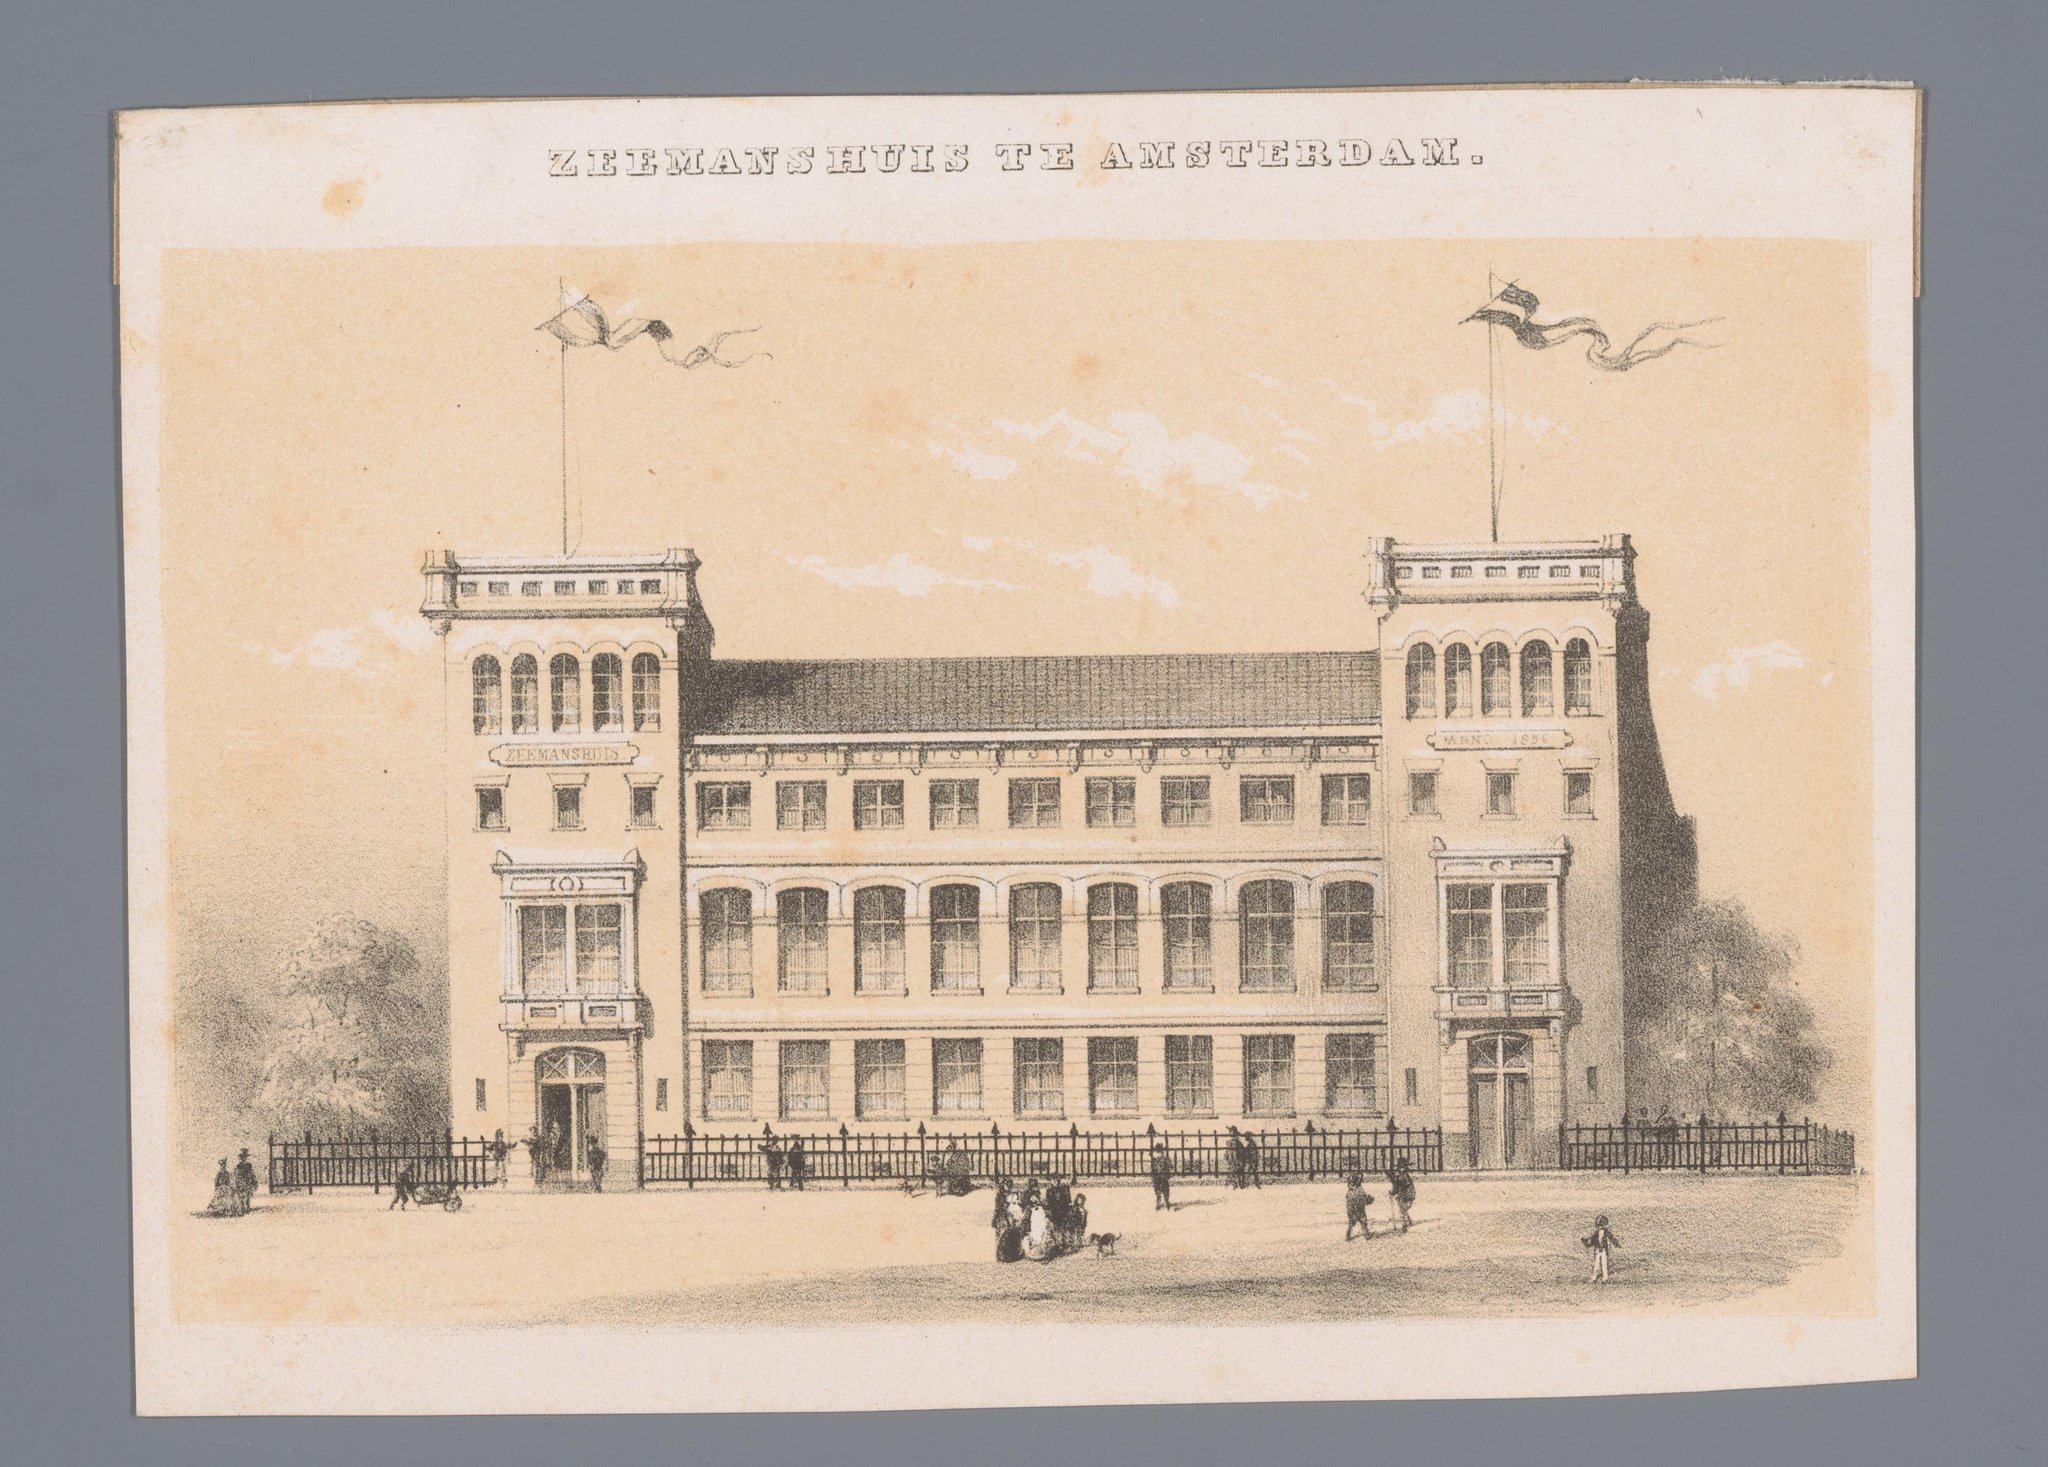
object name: print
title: Zeemanshuis te Amsterdam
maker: Anonymous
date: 1850-1875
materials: paper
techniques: tone lithography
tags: garrison (+ naval force), amsterdam